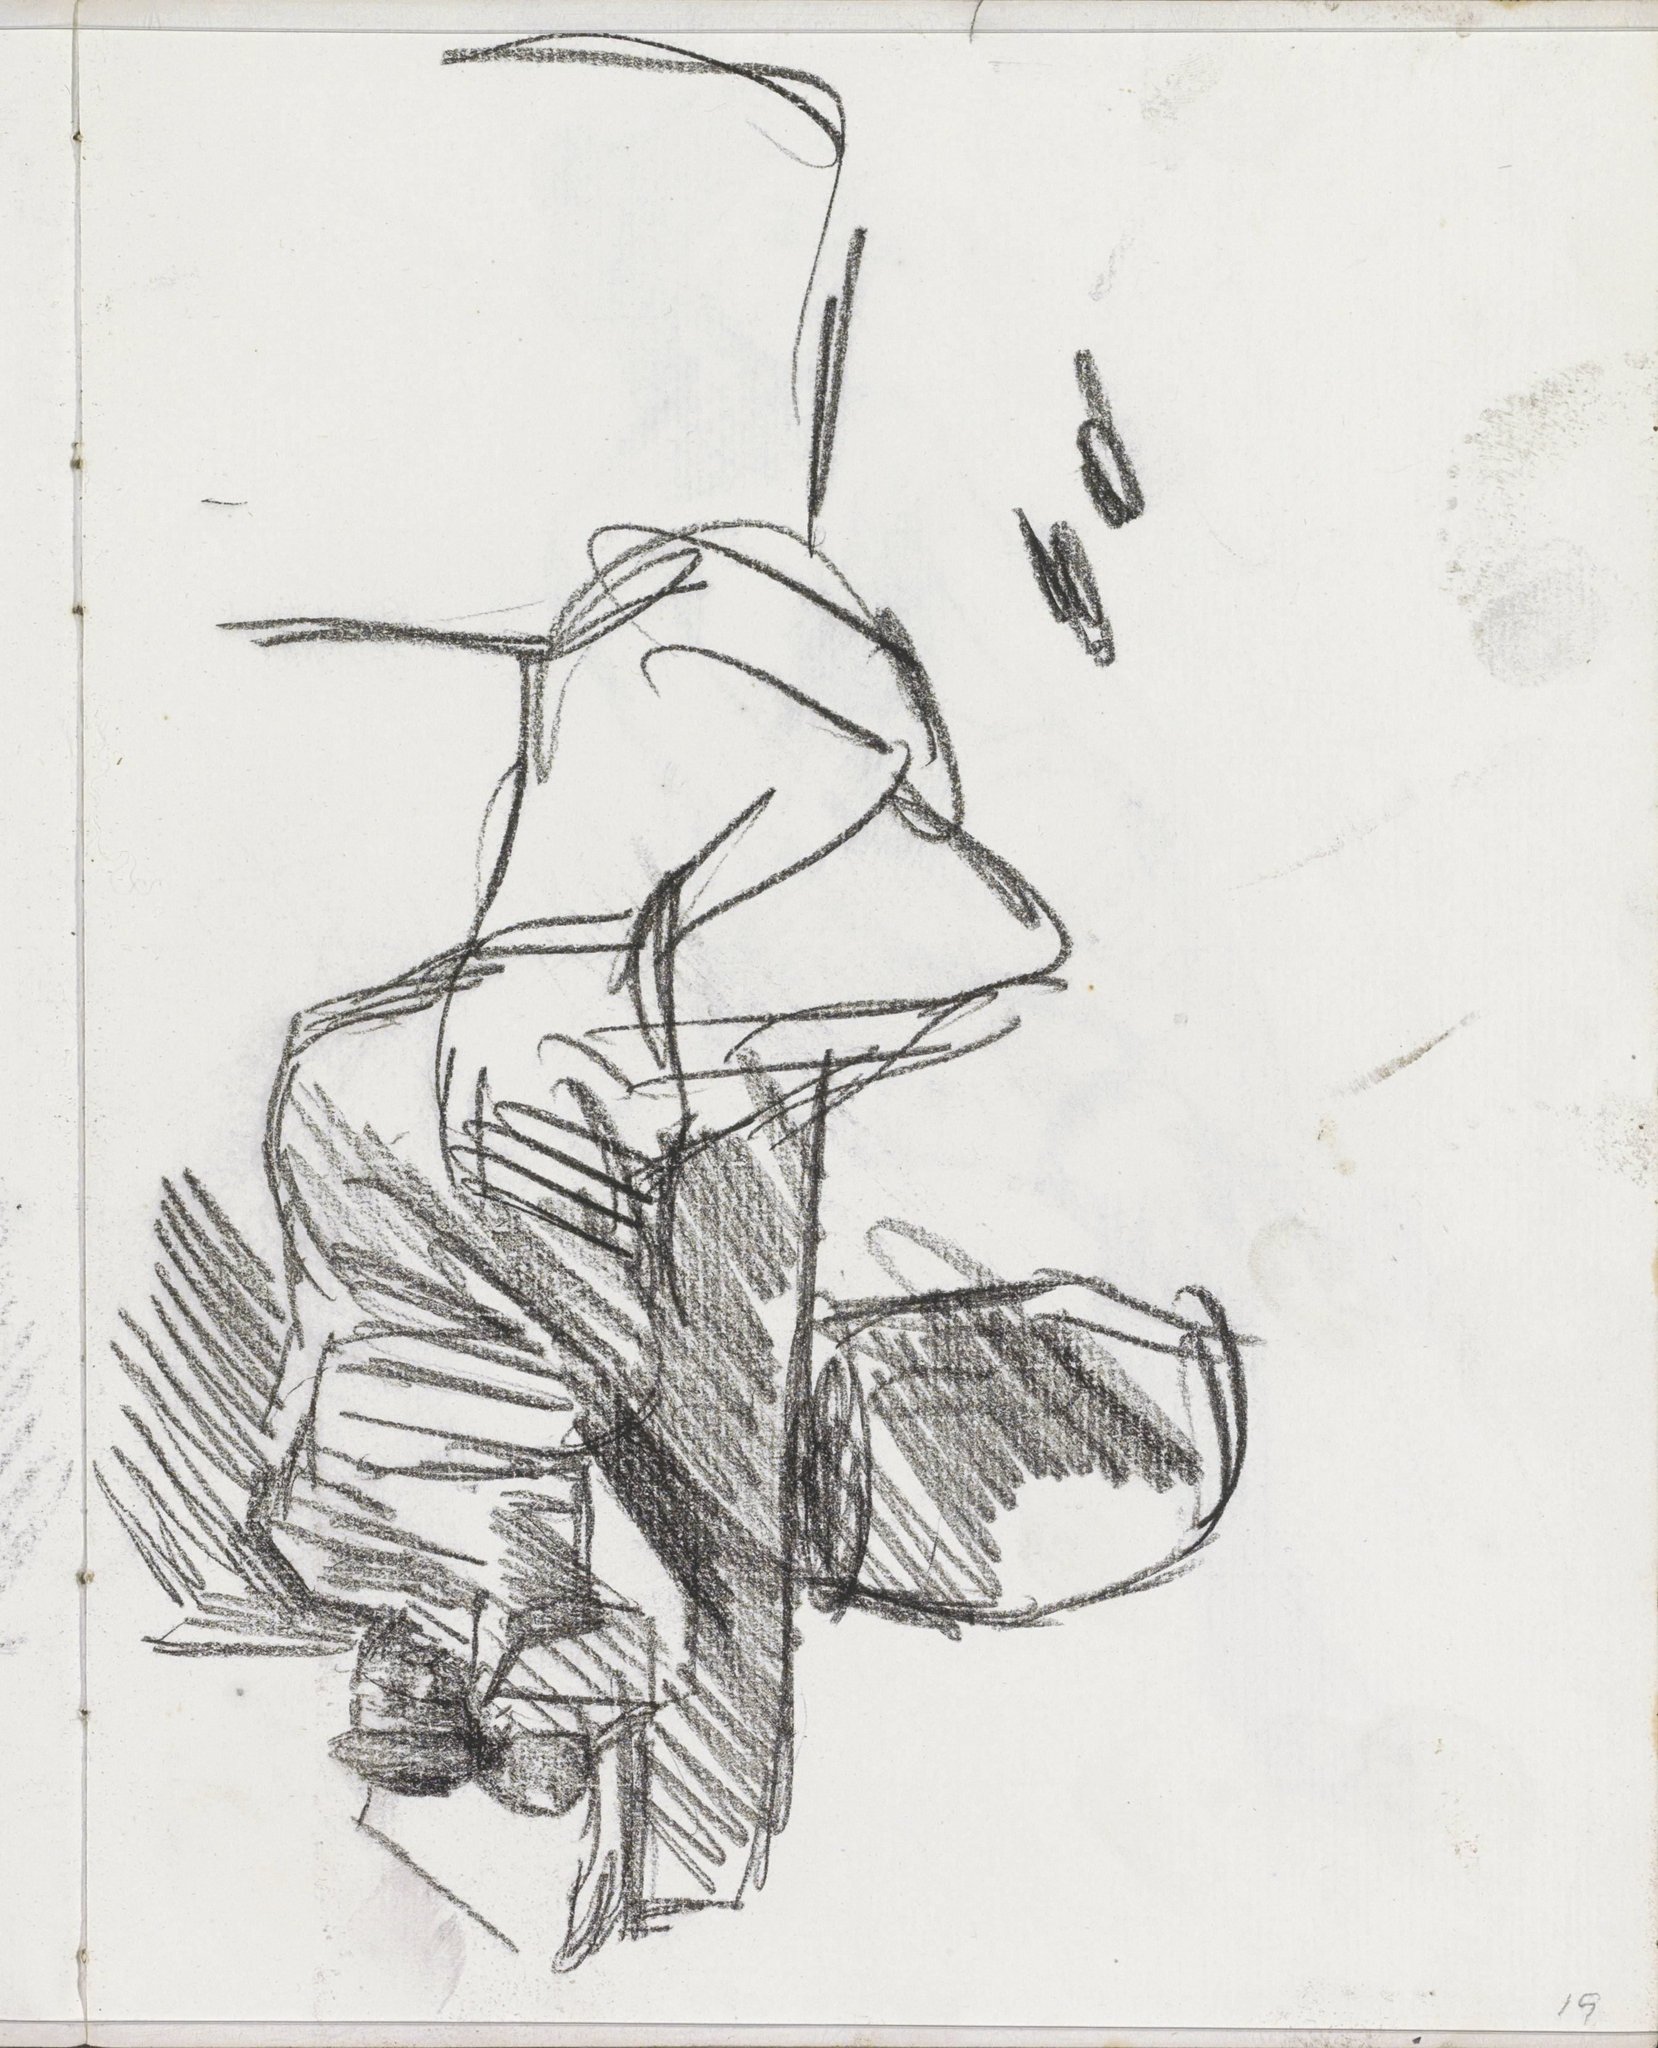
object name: sketchbook leaf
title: Liggende figuur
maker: isaac israels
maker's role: draughtsman, painter, print maker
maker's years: 1865-1934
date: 1875-1934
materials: chalk, paper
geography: the hague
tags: lying figure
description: Op een laag bed. Vooraan een ton of tafel en schoeisel. Blad 19 recto uit schetsboek XIII met 25 bladen.